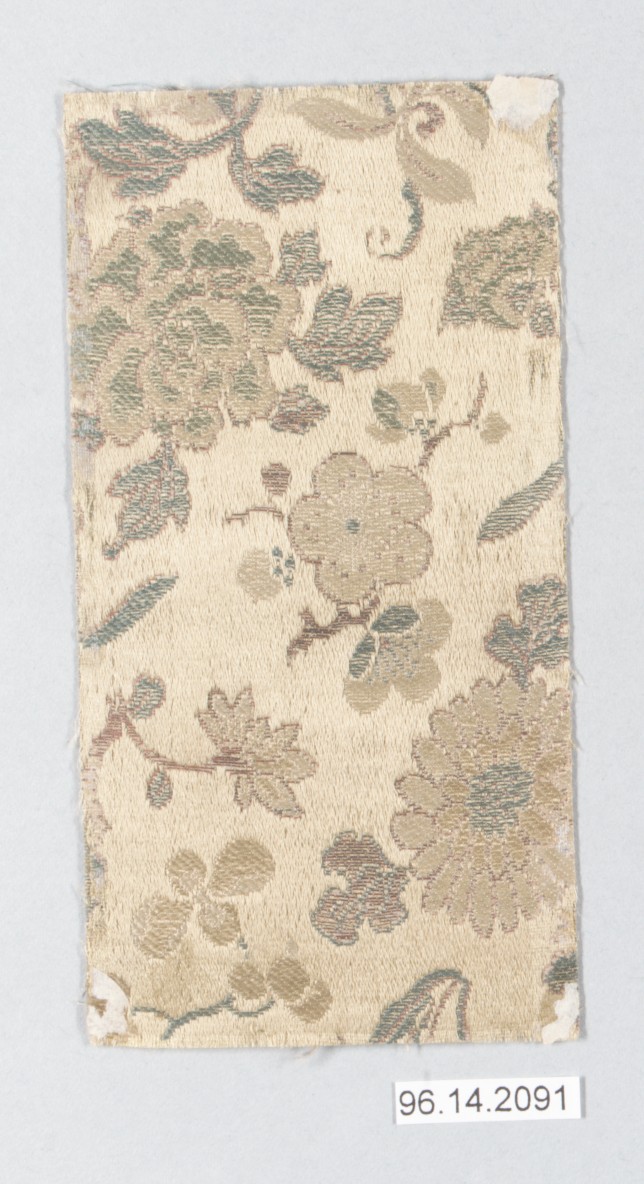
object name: piece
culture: japanese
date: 1701-1900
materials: silk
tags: flowers